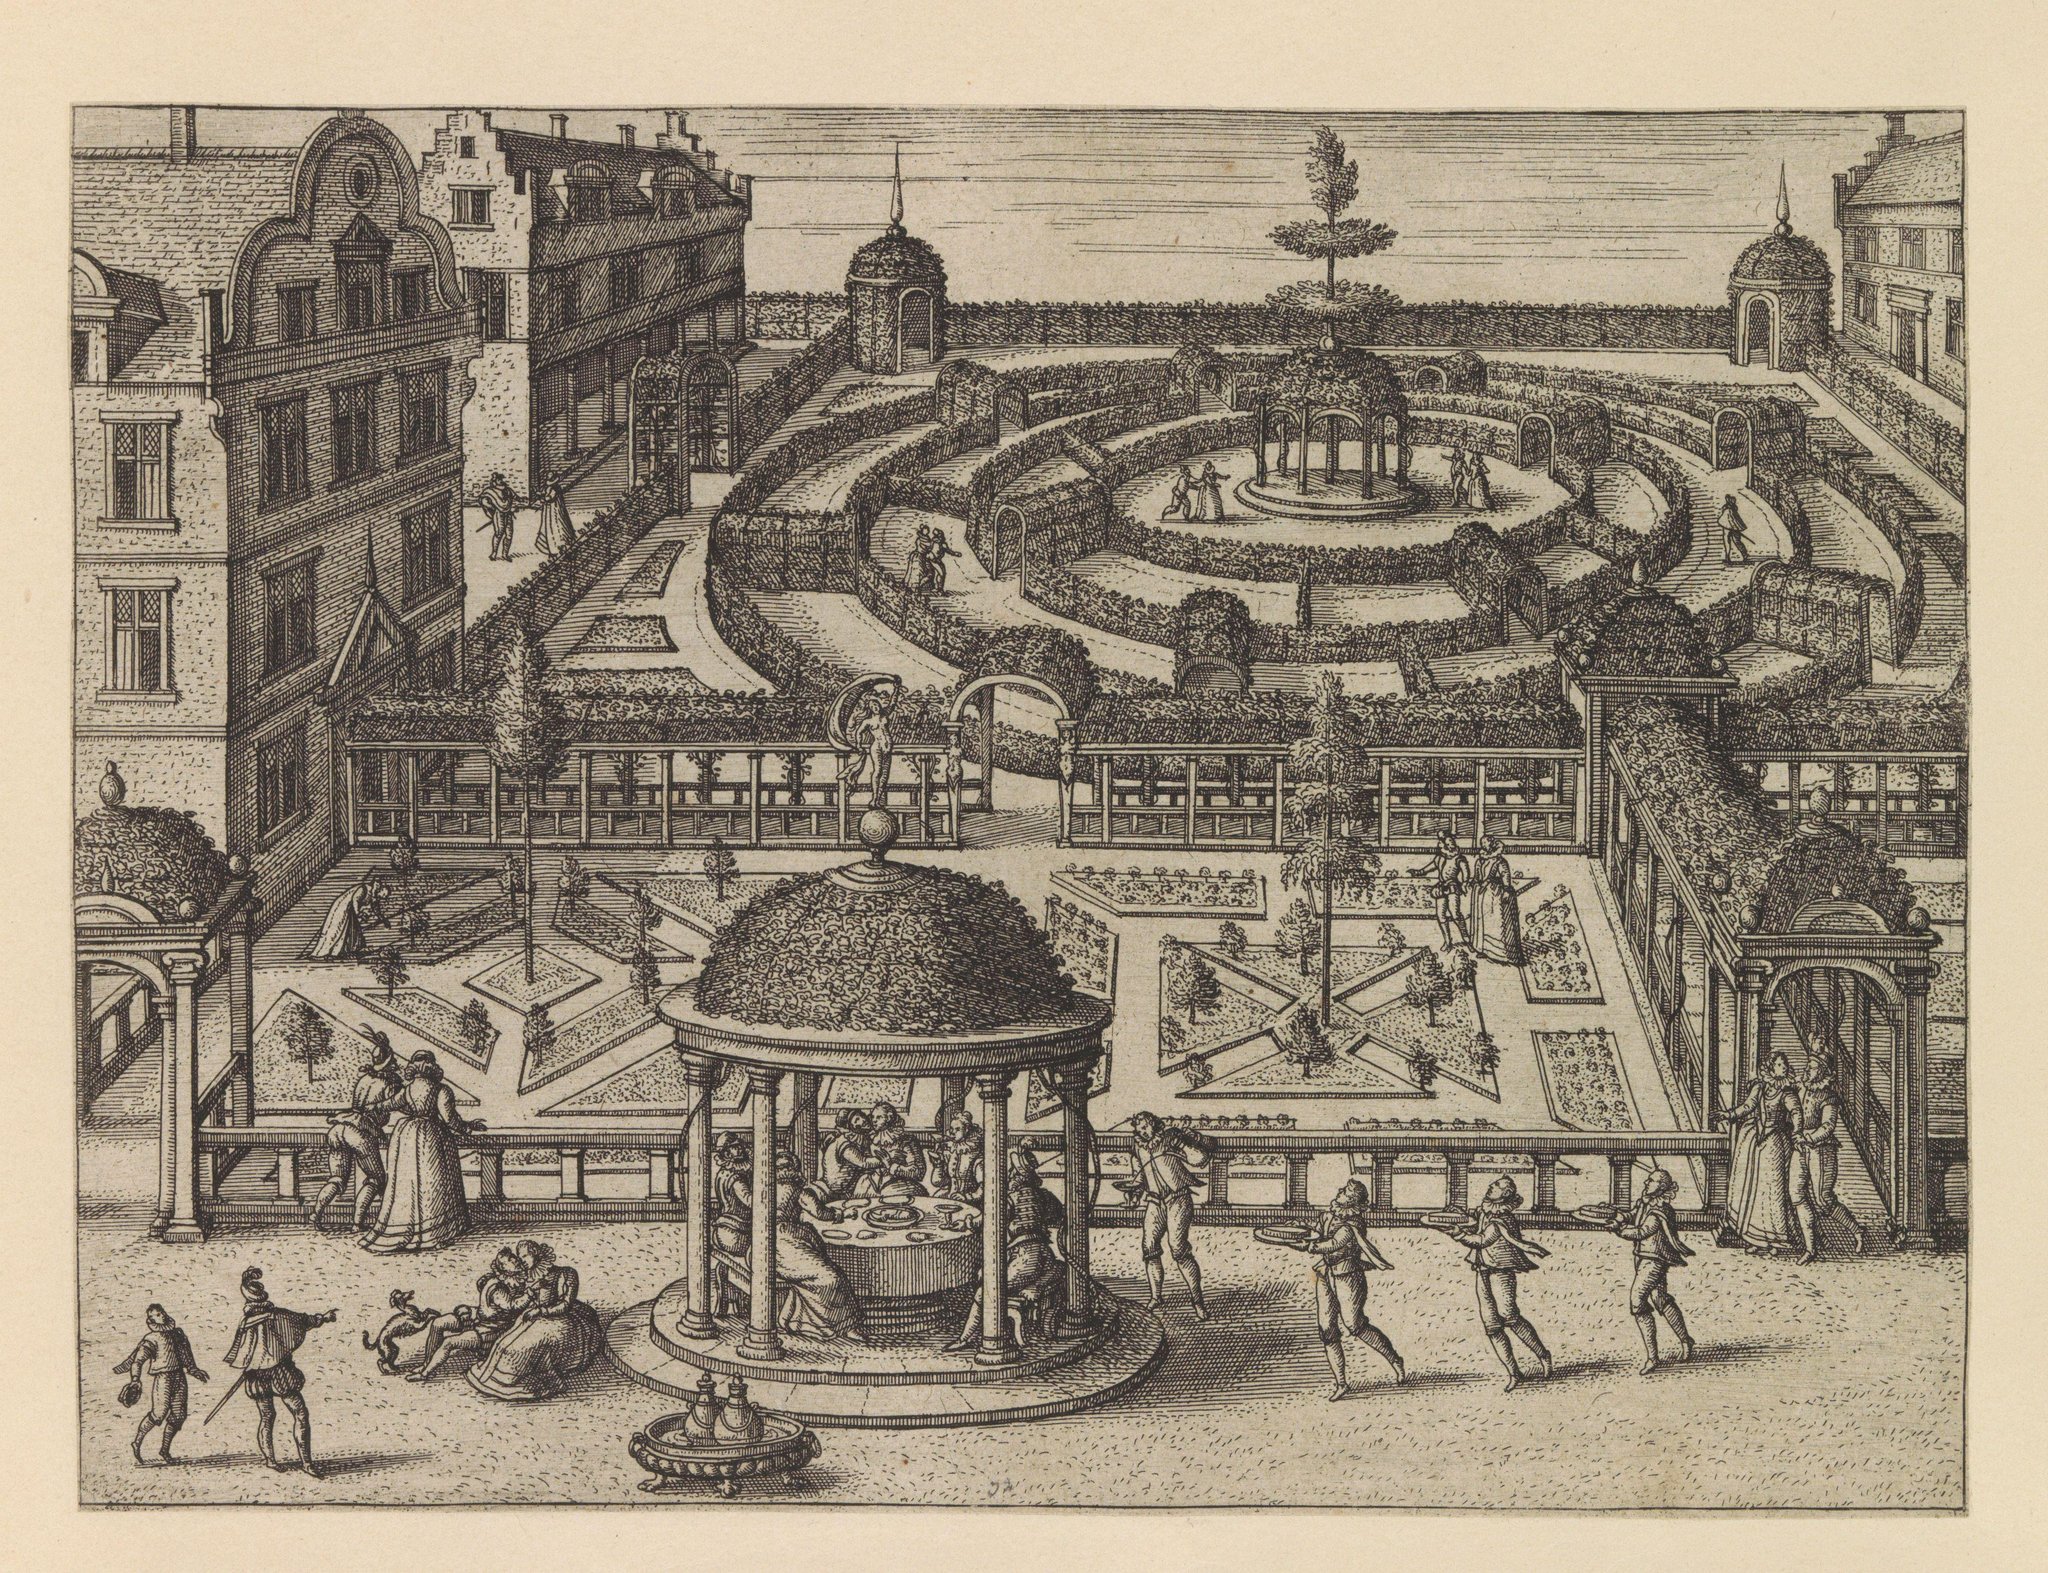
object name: album leaf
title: Tuinen der minne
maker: pieter van der borcht (i)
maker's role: print maker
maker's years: 1545-1608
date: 1587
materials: paper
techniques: etching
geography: antwerp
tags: french or architectonic garden; formal garden, garden of love, court of love, 'fête galante', midday meal, lunch, luck, fortune, lot; 'fato', 'fortuna', 'fortuna aurea', 'fortuna buona', 'fortuna pacifica overo clemente', 'sorte' (ripa), labyrinth, maze ~ garden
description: Een tuin met een prieel waarin een maaltijd wordt genuttigd. Bovenop het prieel is een standbeeld van Fortuna geplaatst. Bedienden zetten aan met gerechten. Een hond (symbool voor de liefde) speelt met een vrijend paar links van het prieel. OP de achtergrond een rond doolhof. De prent maakt deel uit van een album.